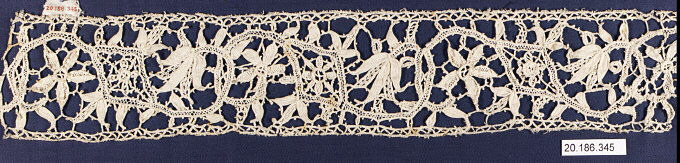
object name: insertion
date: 1601-1633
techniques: lace